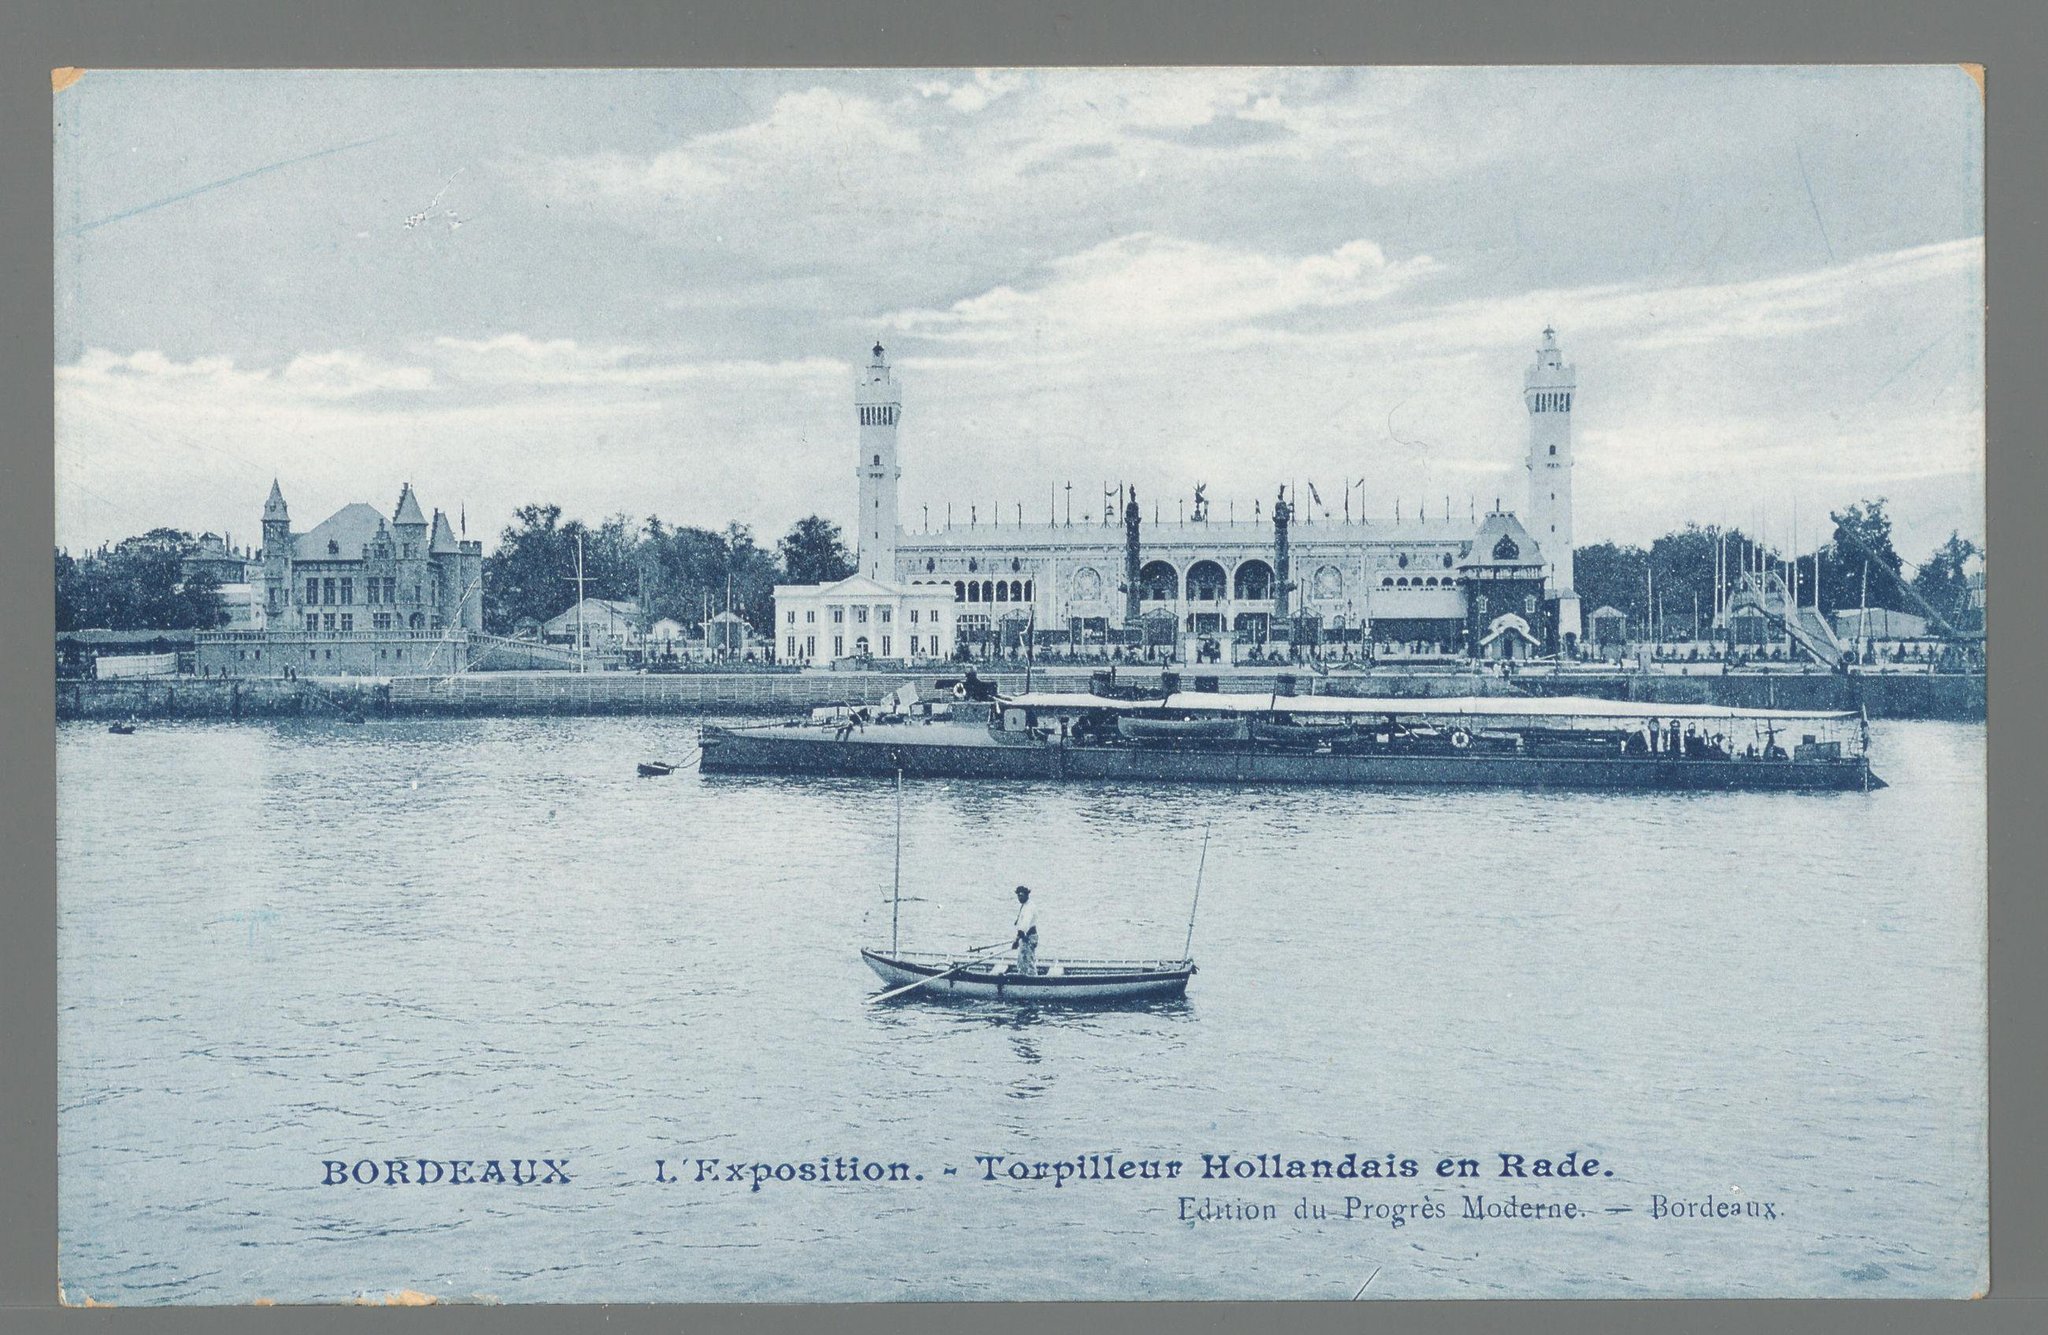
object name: ansichtkaart, prentbriefkaart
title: Bordeaux. L'Exposition. Torpilleur Hollandais en Rade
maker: Anonymous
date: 1907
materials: cardboard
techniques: photograph, writing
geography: bordeaux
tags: world fair, world exhibition, ships (in general), city-view, and landscape with man-made constructions (+ city(-scape) with figures, staffage)